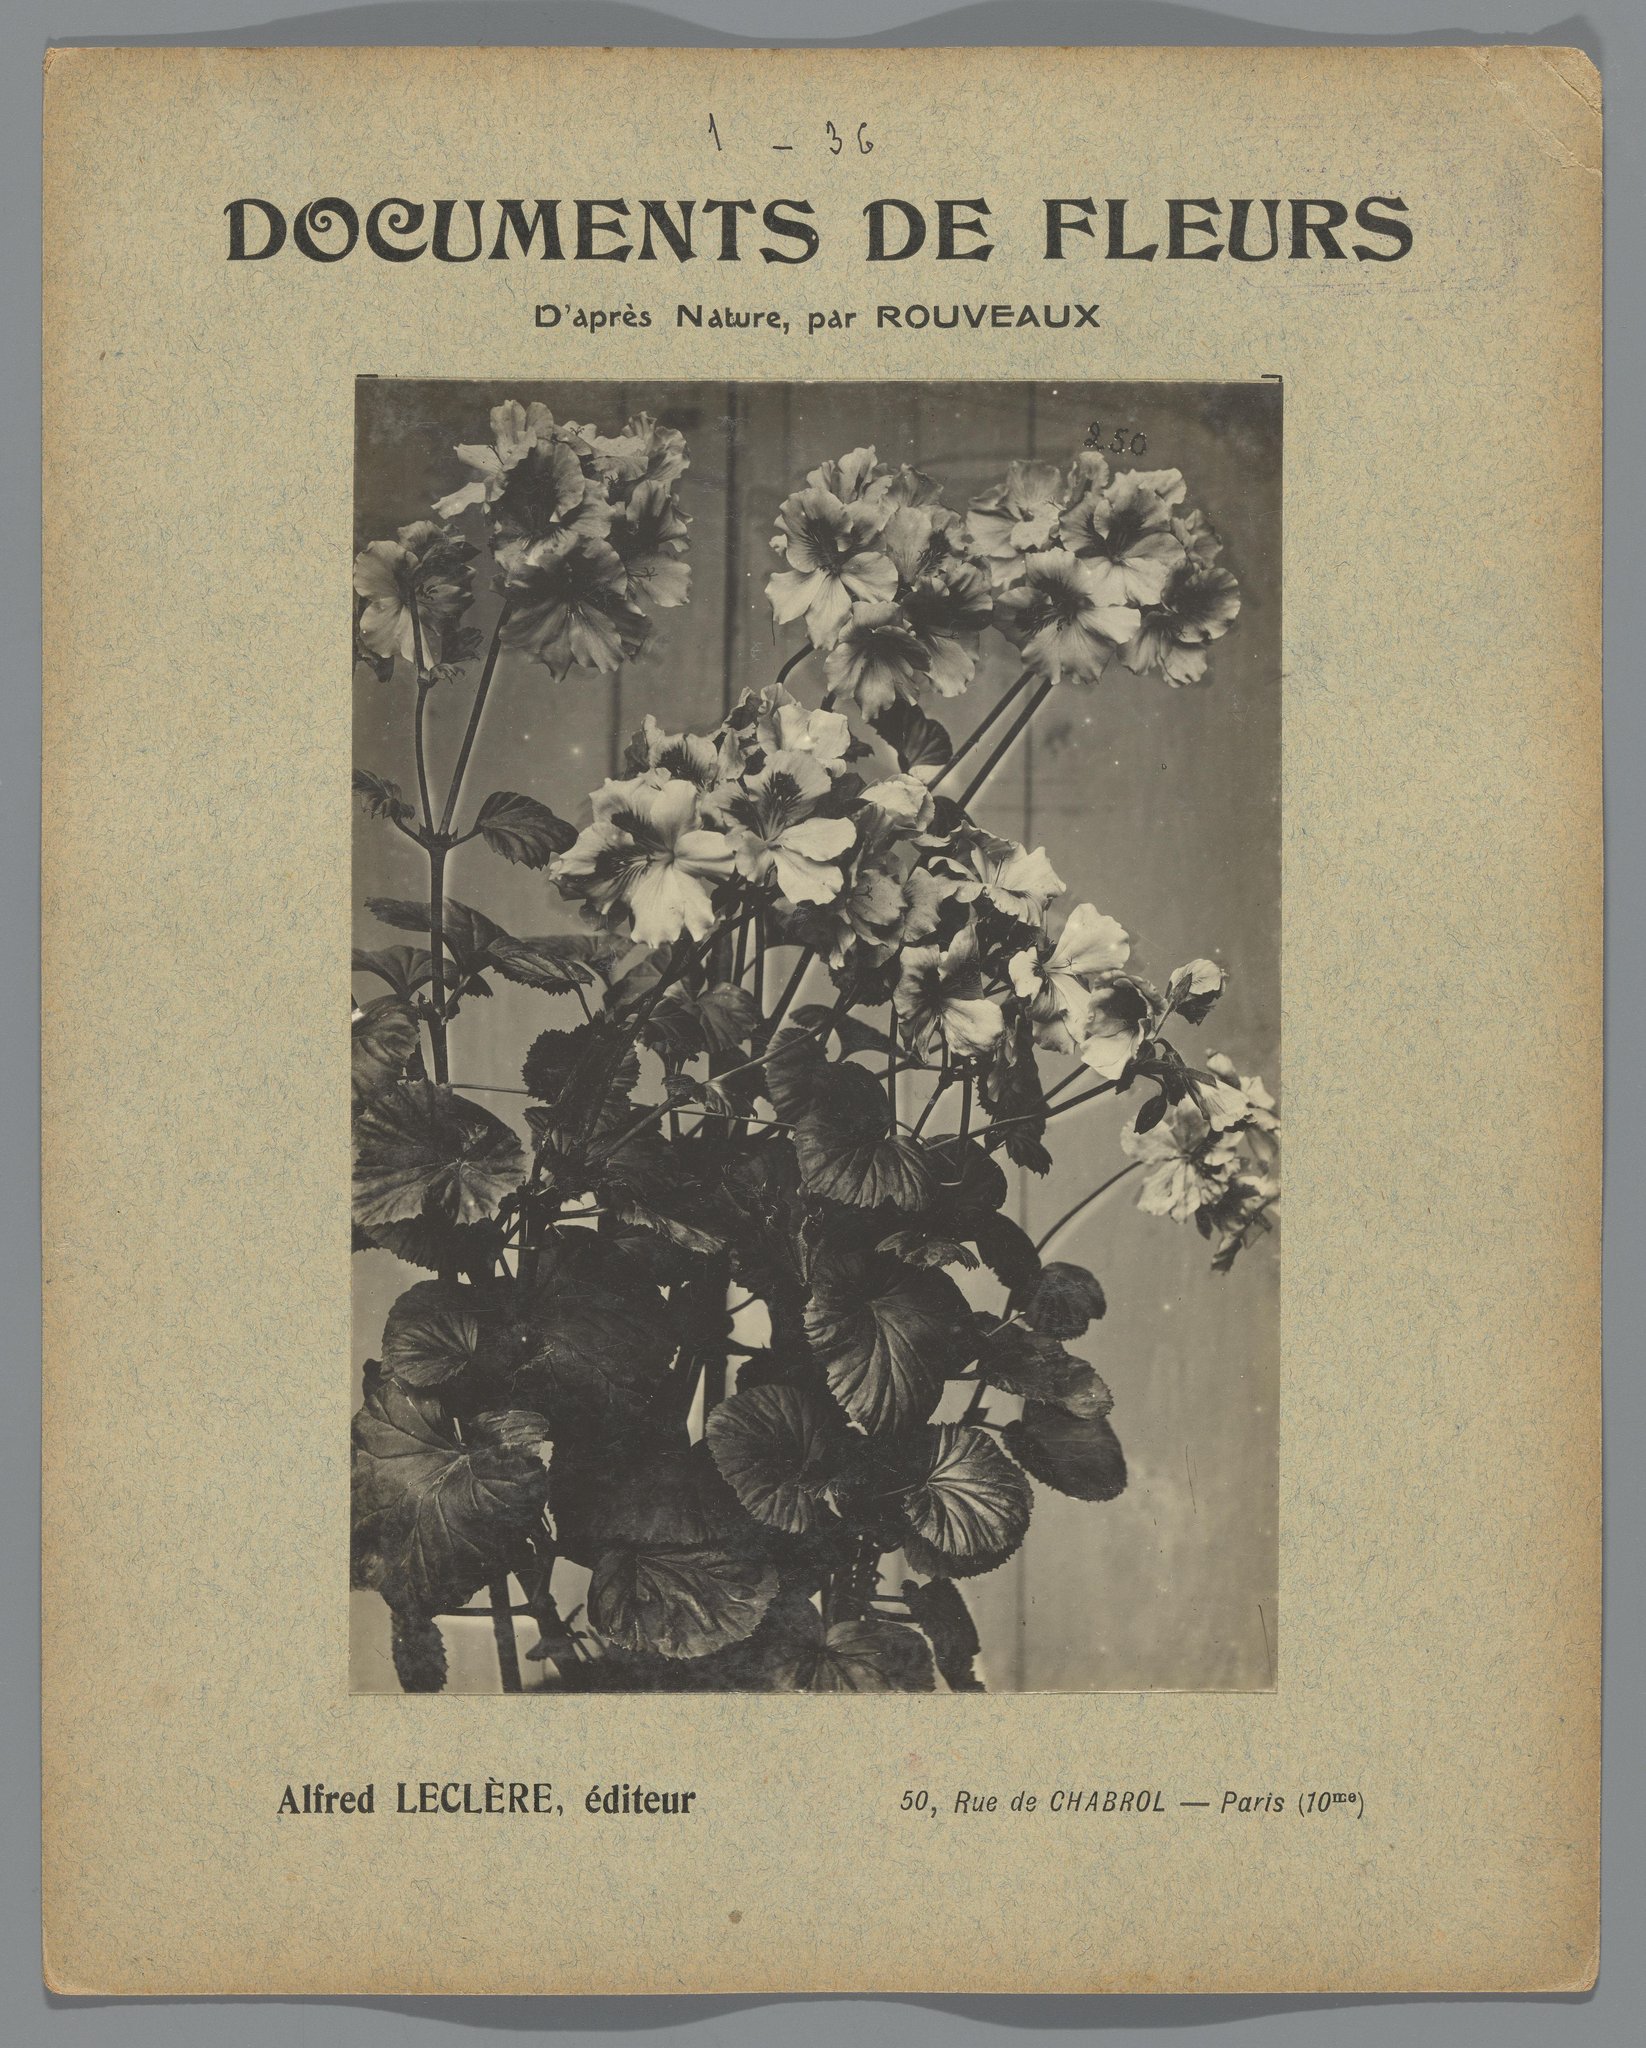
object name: photograph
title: Bloemstudie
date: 1895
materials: photographic support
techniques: gelatin silver print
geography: france